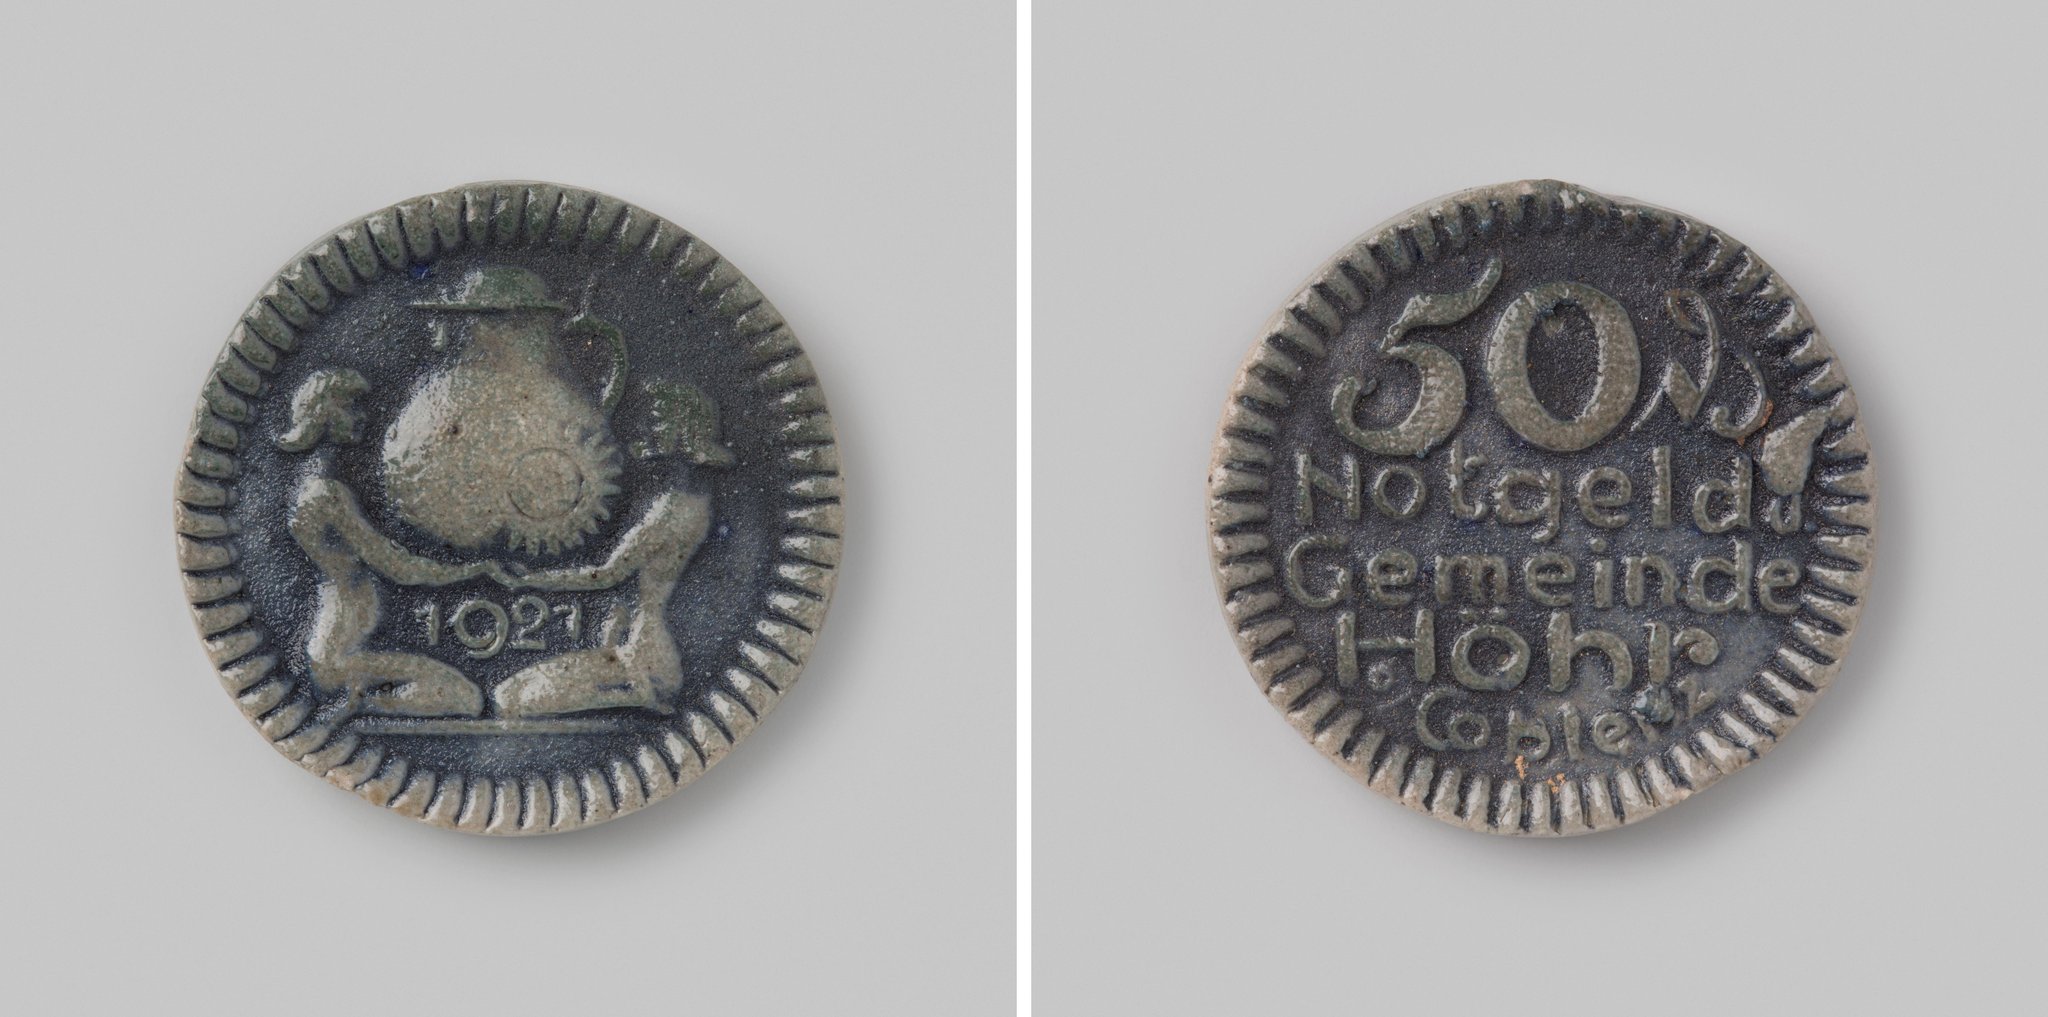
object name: coin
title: 50 mark notgeld uit Duitsland, Höhr, Coblenz, 1921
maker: a. kamp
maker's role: sculptor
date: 1921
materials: porcelain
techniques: casting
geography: höhr-grenzhausen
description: Porseleinen zwart gekleurde pseudomunt. Voorzijde: jongen en meisje die een schenkkan dragen. Tussen beiden jaartal. Keerzijde: waarde-aanduiding in twee regels, waaronder plaats-aanduiding in drie regels. Gladde rand.